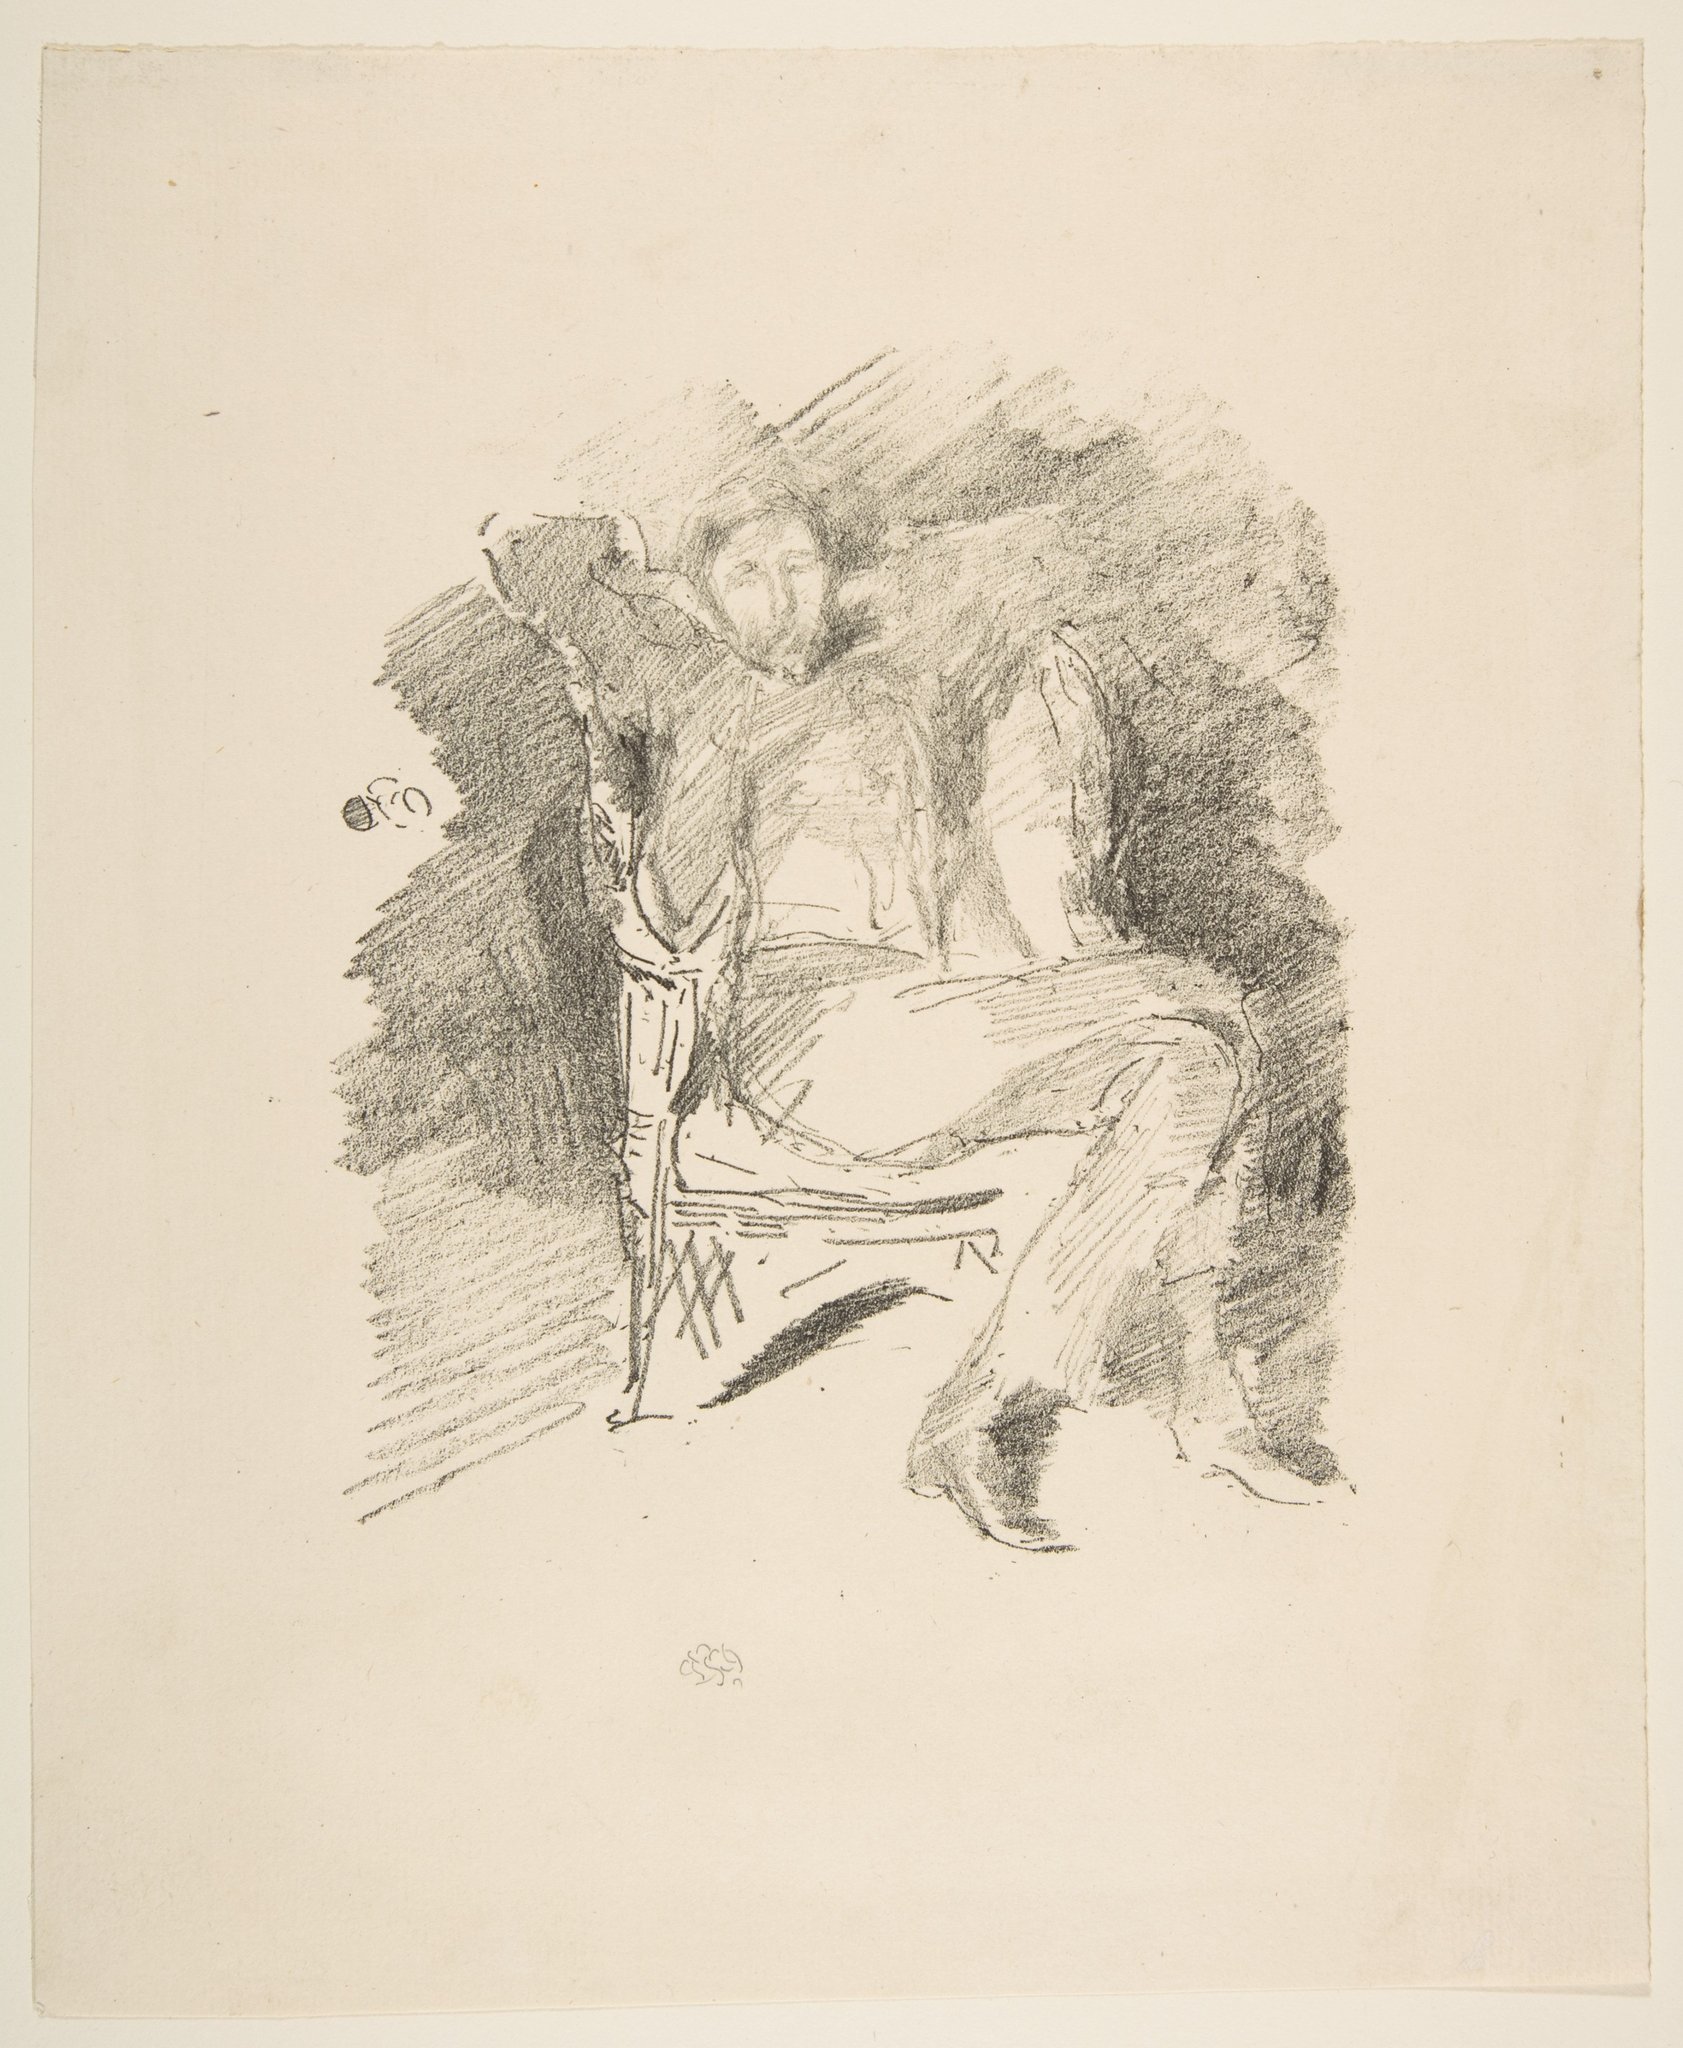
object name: print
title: Firelight (Joseph Pennell, No. 1)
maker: james mcneill whistler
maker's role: artist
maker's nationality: american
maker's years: 1834-1903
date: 1896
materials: ink, paper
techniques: printing, lithography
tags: men